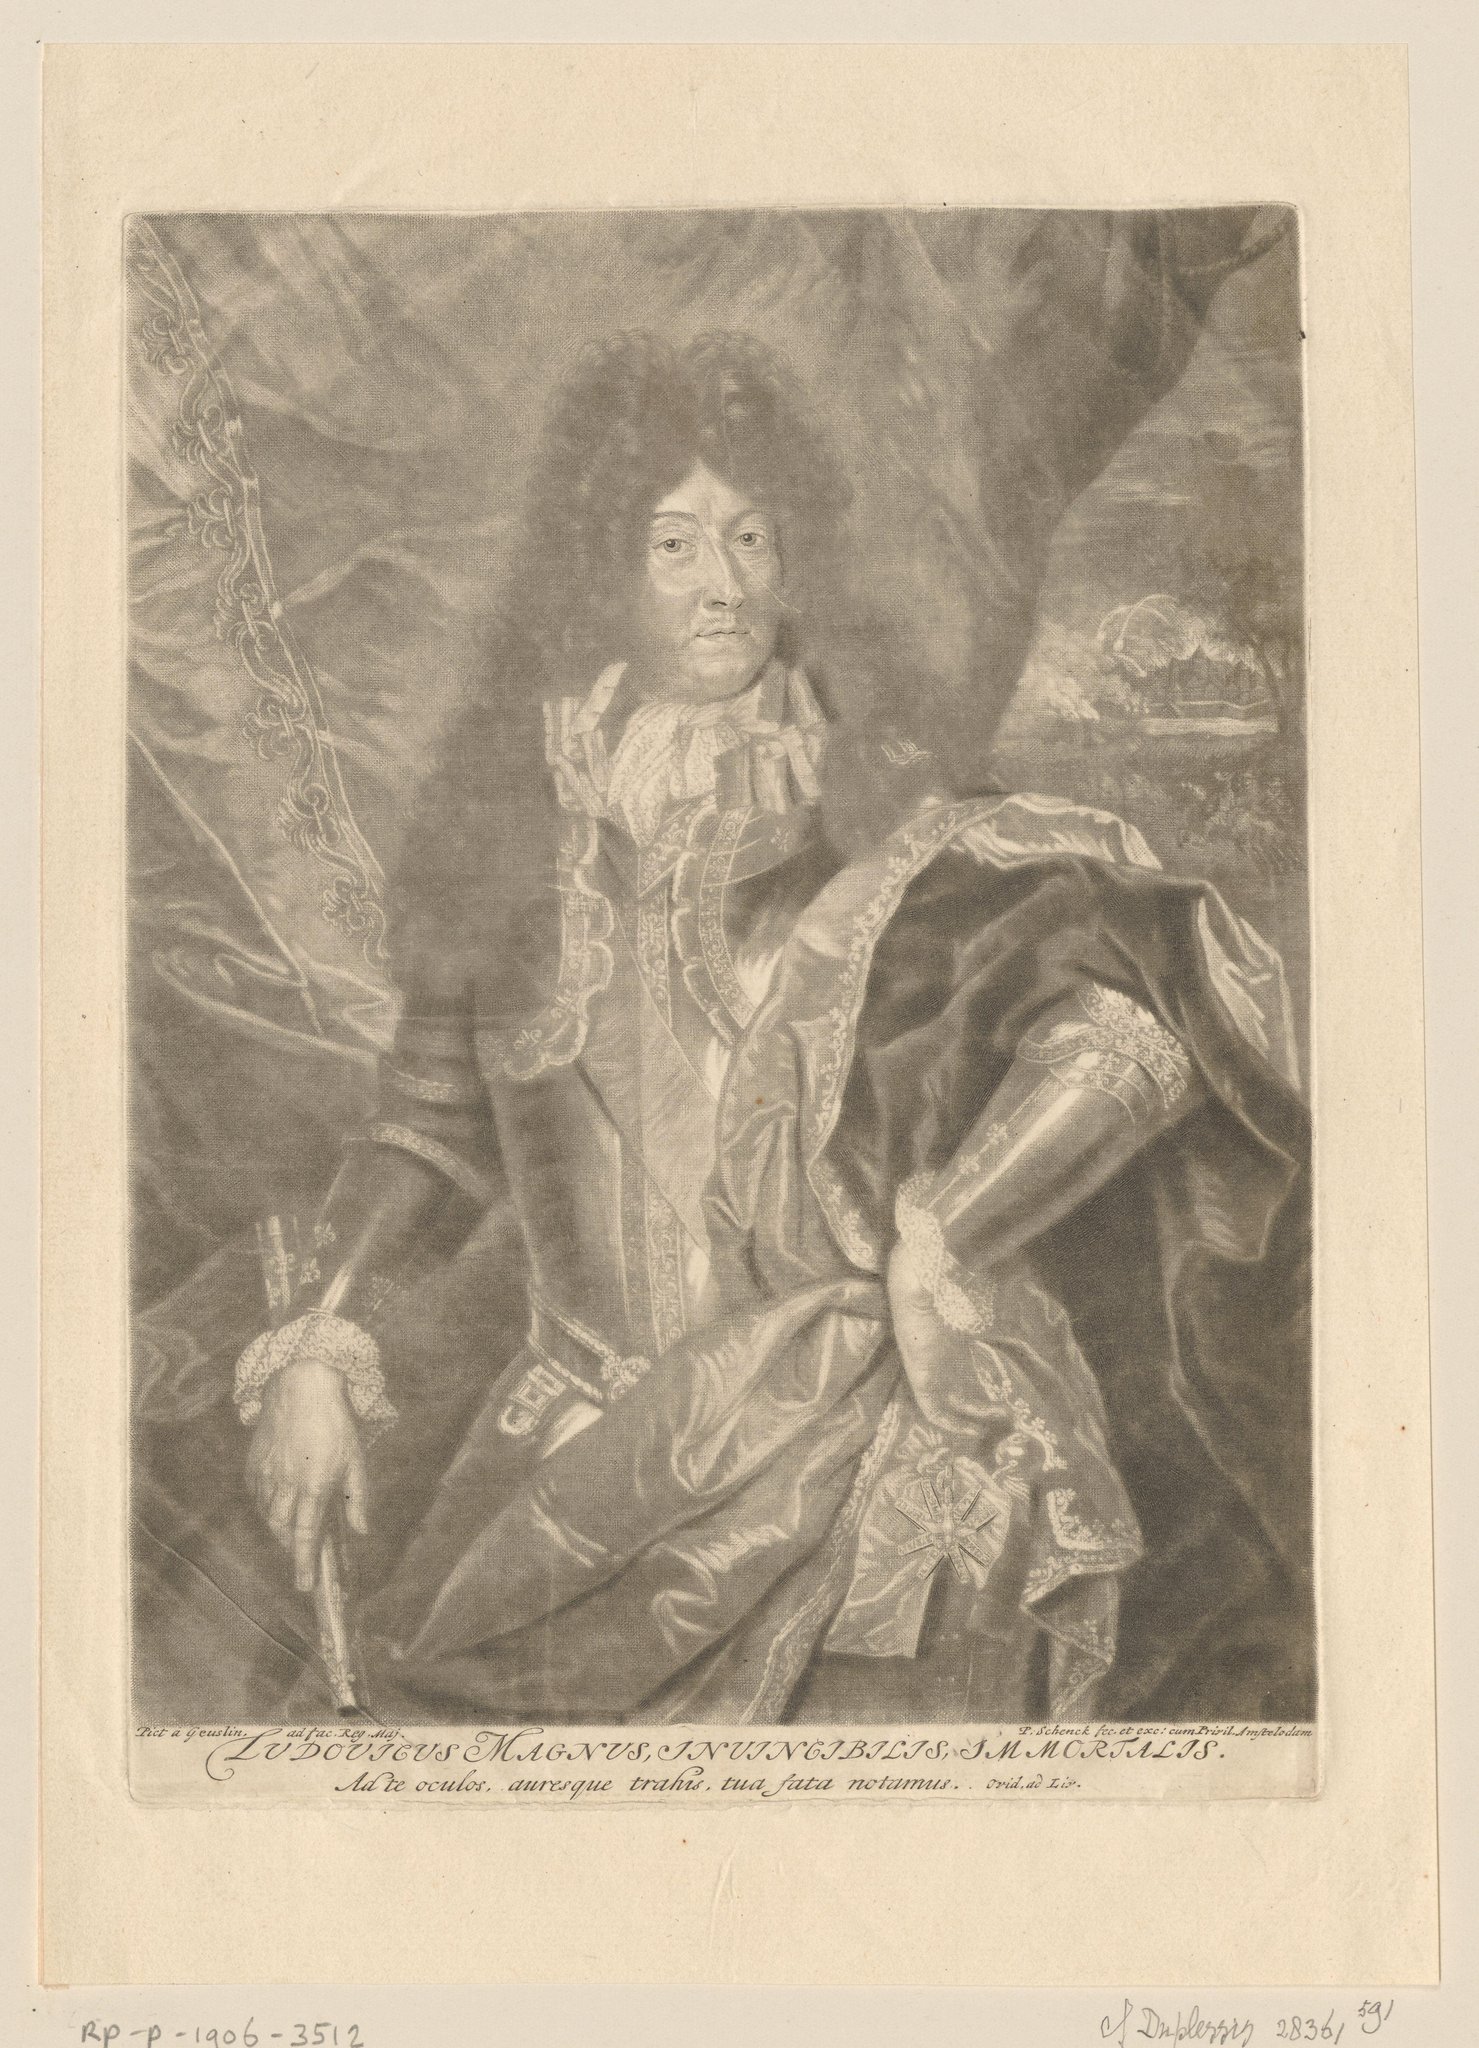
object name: print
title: Portret van Lodewijk XIV van Frankrijk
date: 1700-1711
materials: paper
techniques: engraving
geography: amsterdam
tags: lodewijk xiv (koning van frankrijk), armour, historical persons, battle, king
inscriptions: collector's mark: Lugt 2228